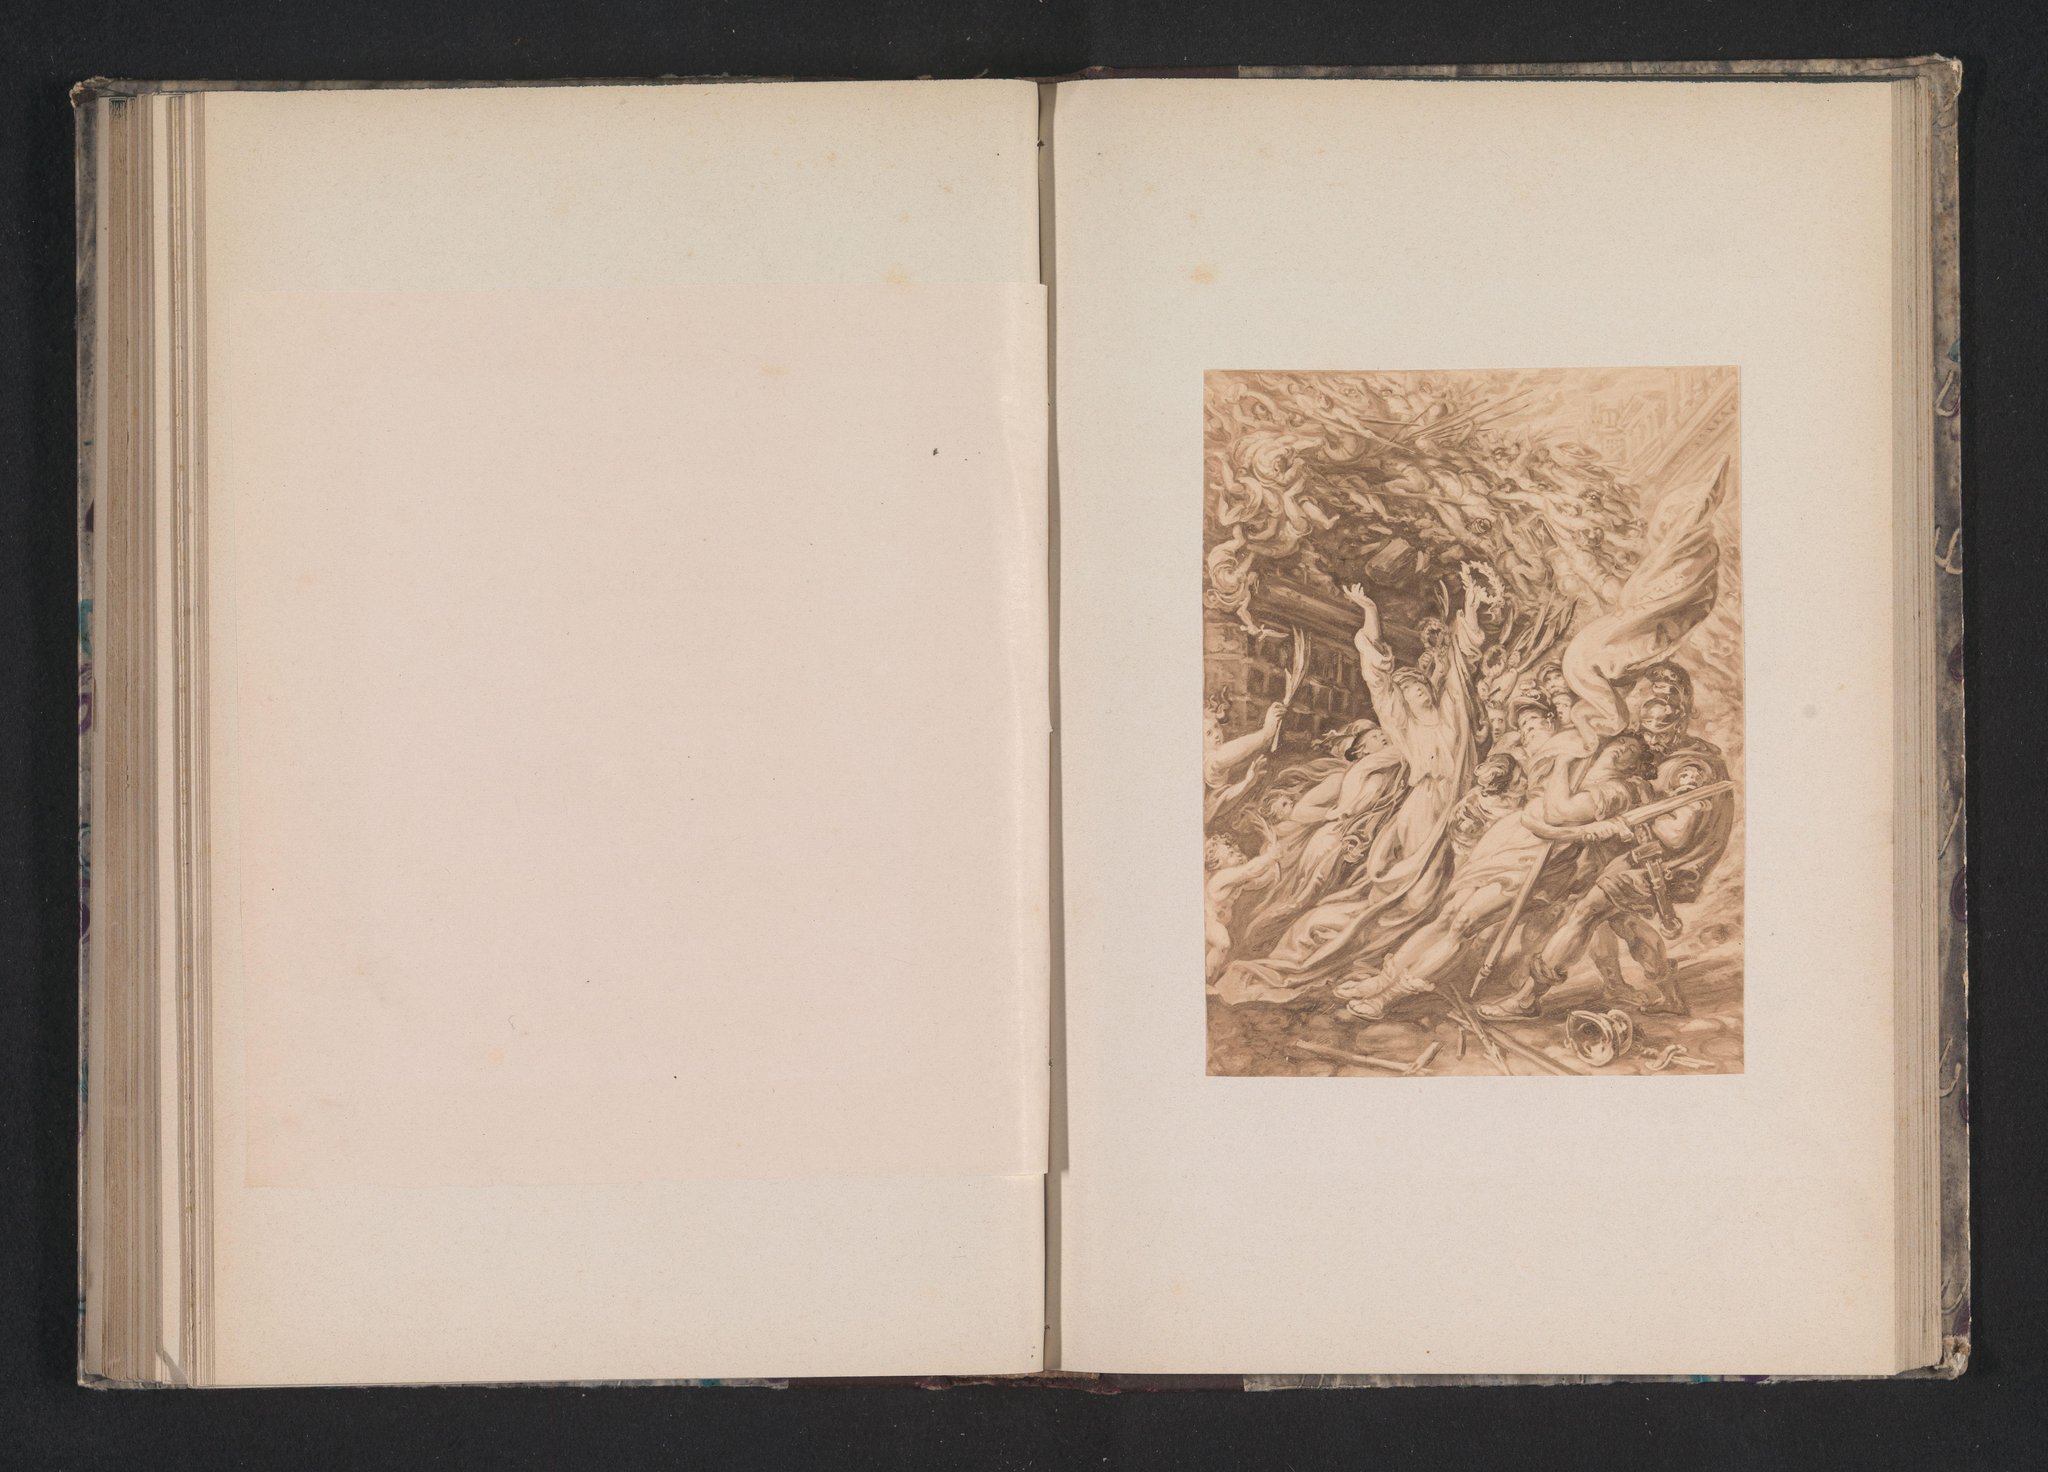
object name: photograph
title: Fotoreproductie van een werk met mogelijk een allegorische voorstelling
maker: Anonymous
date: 1857-1862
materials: photographic support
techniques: albumen print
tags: the graphic arts, classical mythology and ancient history